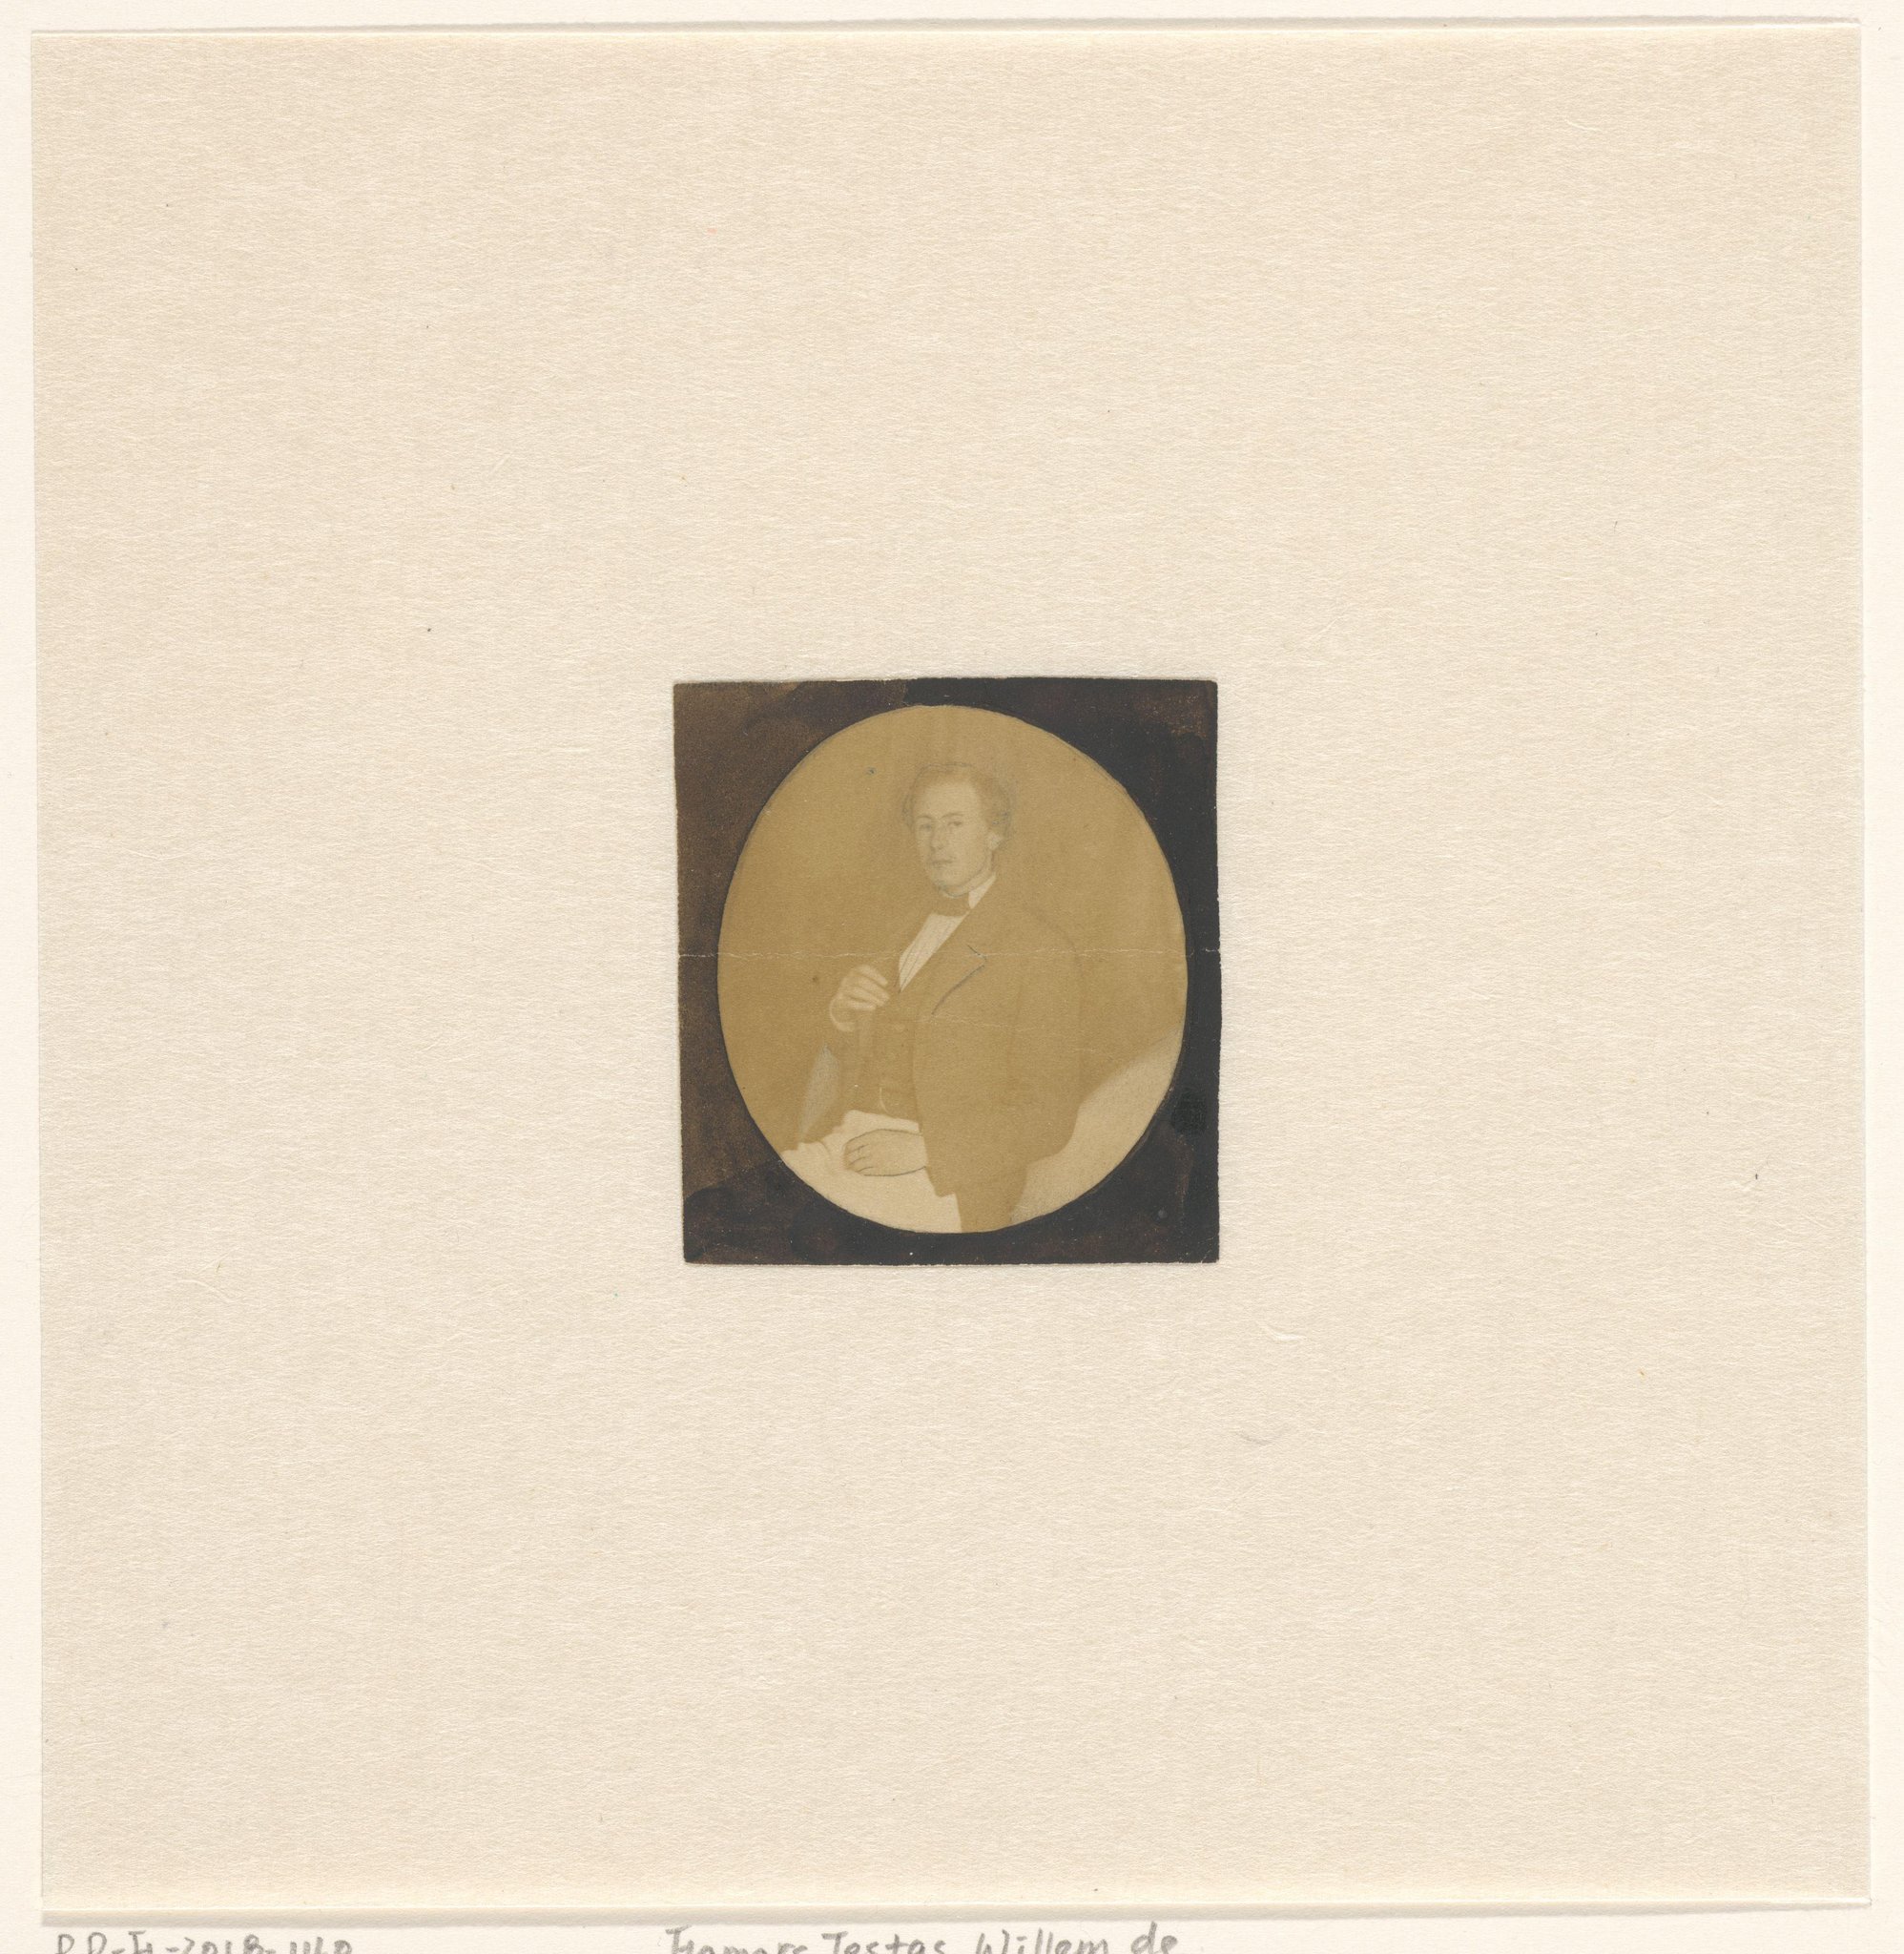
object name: photograph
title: Vermoedelijk Zelfportret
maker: willem de famars testas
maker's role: draughtsman, painter, print maker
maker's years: 1834-1896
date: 1806-1858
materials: paint, photographic support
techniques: salted paper print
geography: alexandria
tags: portrait, self-portrait of artist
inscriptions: inscription: ‘Alexandrie Juny 1858’, inscription: ‘1082/7 (M v W)’